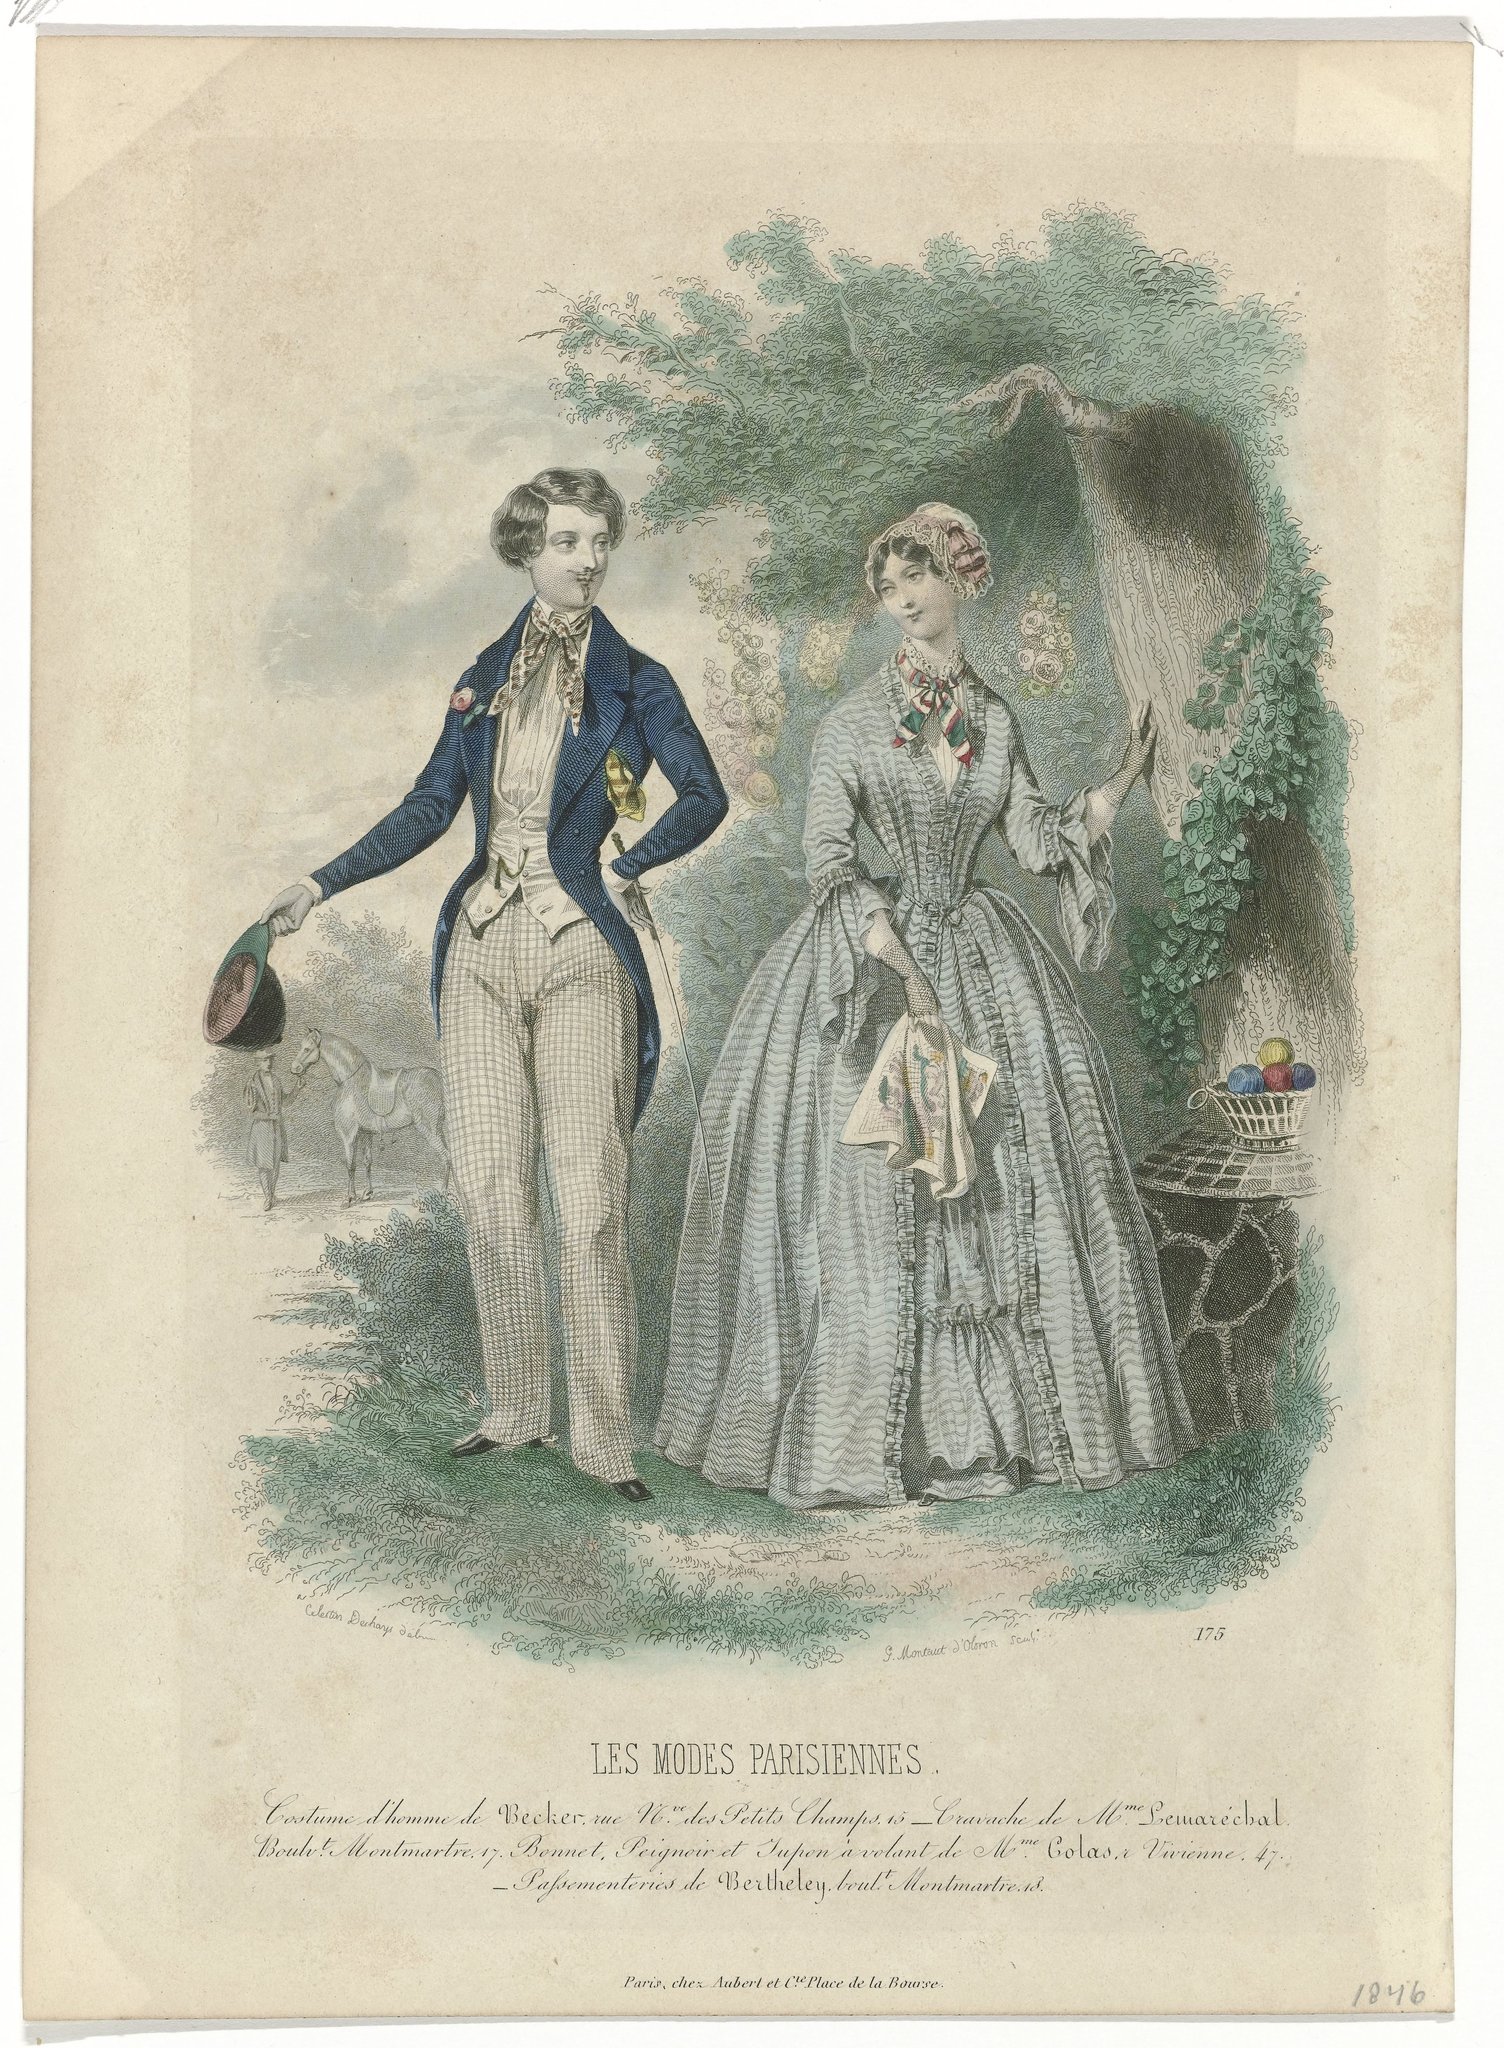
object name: fashion print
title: Les Modes Parisiennes 1846, No. 175 : Costume d'homme de Becker (...)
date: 1846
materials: paper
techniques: engraving, hand coloring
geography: paris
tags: clothing for the upper part of the body (vest) (+ men's clothes), neck-gear ~ clothing (neckerchief) (+ men's clothes), ornamental parts of clothing (+ women's clothes), trousers, breeches, etc. (pantalon) (+ men's clothes), gloves, mittens (mitaines) (+ women's clothes), underclothes for the lower part of the body (+ women's clothes), coat (+ men's clothes), coat (housecoat) (+ women's clothes), head-gear: cap (+ women's clothes), fashion plates, (other forms of) needlework, e.g.: crocheting, knitting, embroidering, leading a horse by the reins; rider beside his horse, whip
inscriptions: caption: ‘Costume d'homme de Becker, rue N.ve des Petits Champs, 15 _ cravache de M.me Lemaréchal. Boulv.t Montmartre, 17. Bonnet, Peignoir et jupon à volant de M.me Colas, r. Vivienne, 47._ Passementeries de Bertheley, boul.t Montmartre. 18.’, address: ‘Paris chez Aubert et C.ie Place de la Bourse.’, title: ‘Les Modes Parisiennes.’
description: Een man en een vrouw bij een boom in een tuin. Zij heeft een borduurwerk in de hand; op de tafel een mandje met bollen wol. Op de achtergrond een man met een paard aan de teugel. Volgens het onderschrift: mannenkostuum van Becker. Rijzweep van Lemaréchal. Muts, gestreepte 'peignoir' en onderrok met gerimpelde strook stof van Colas. Passementerie van Bertheley. Prent uit het modetijdschrift Les Modes Parisiennes (1843-1885).